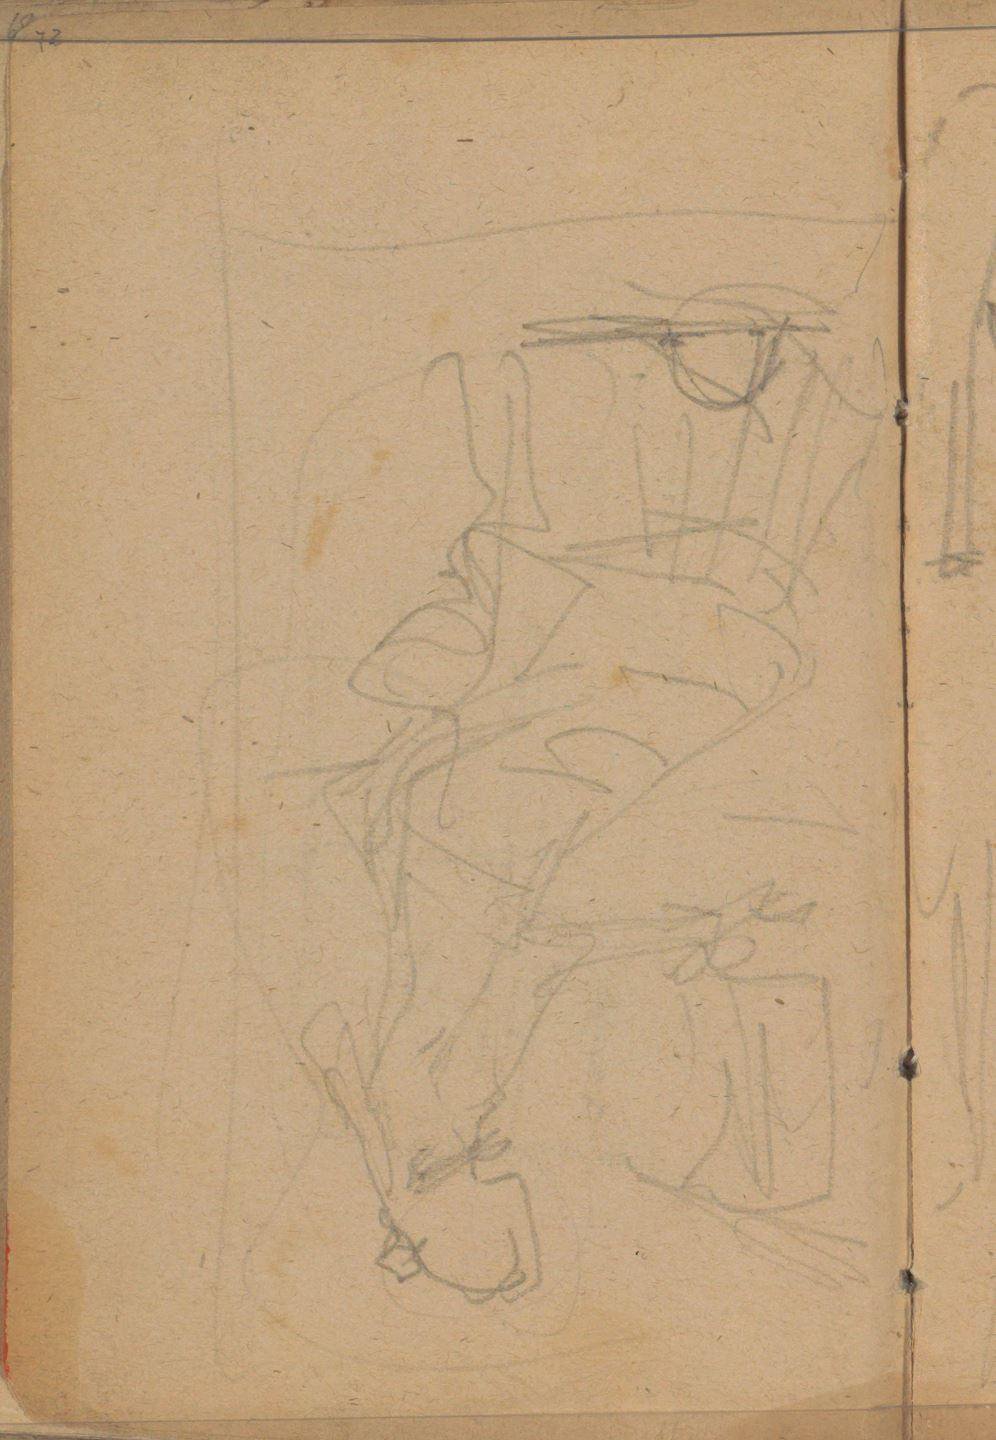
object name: sketchbook leaf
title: Vrouw achter een piano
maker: george hendrik breitner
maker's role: draughtsman, painter, print maker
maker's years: 1857-1923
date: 1881-1883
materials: paper, pencil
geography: south holland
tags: sitting figure - aa - female human figure, grand piano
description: Vrouw achter een piano. Pagina 72 uit een schetsboek met 70 bladen.